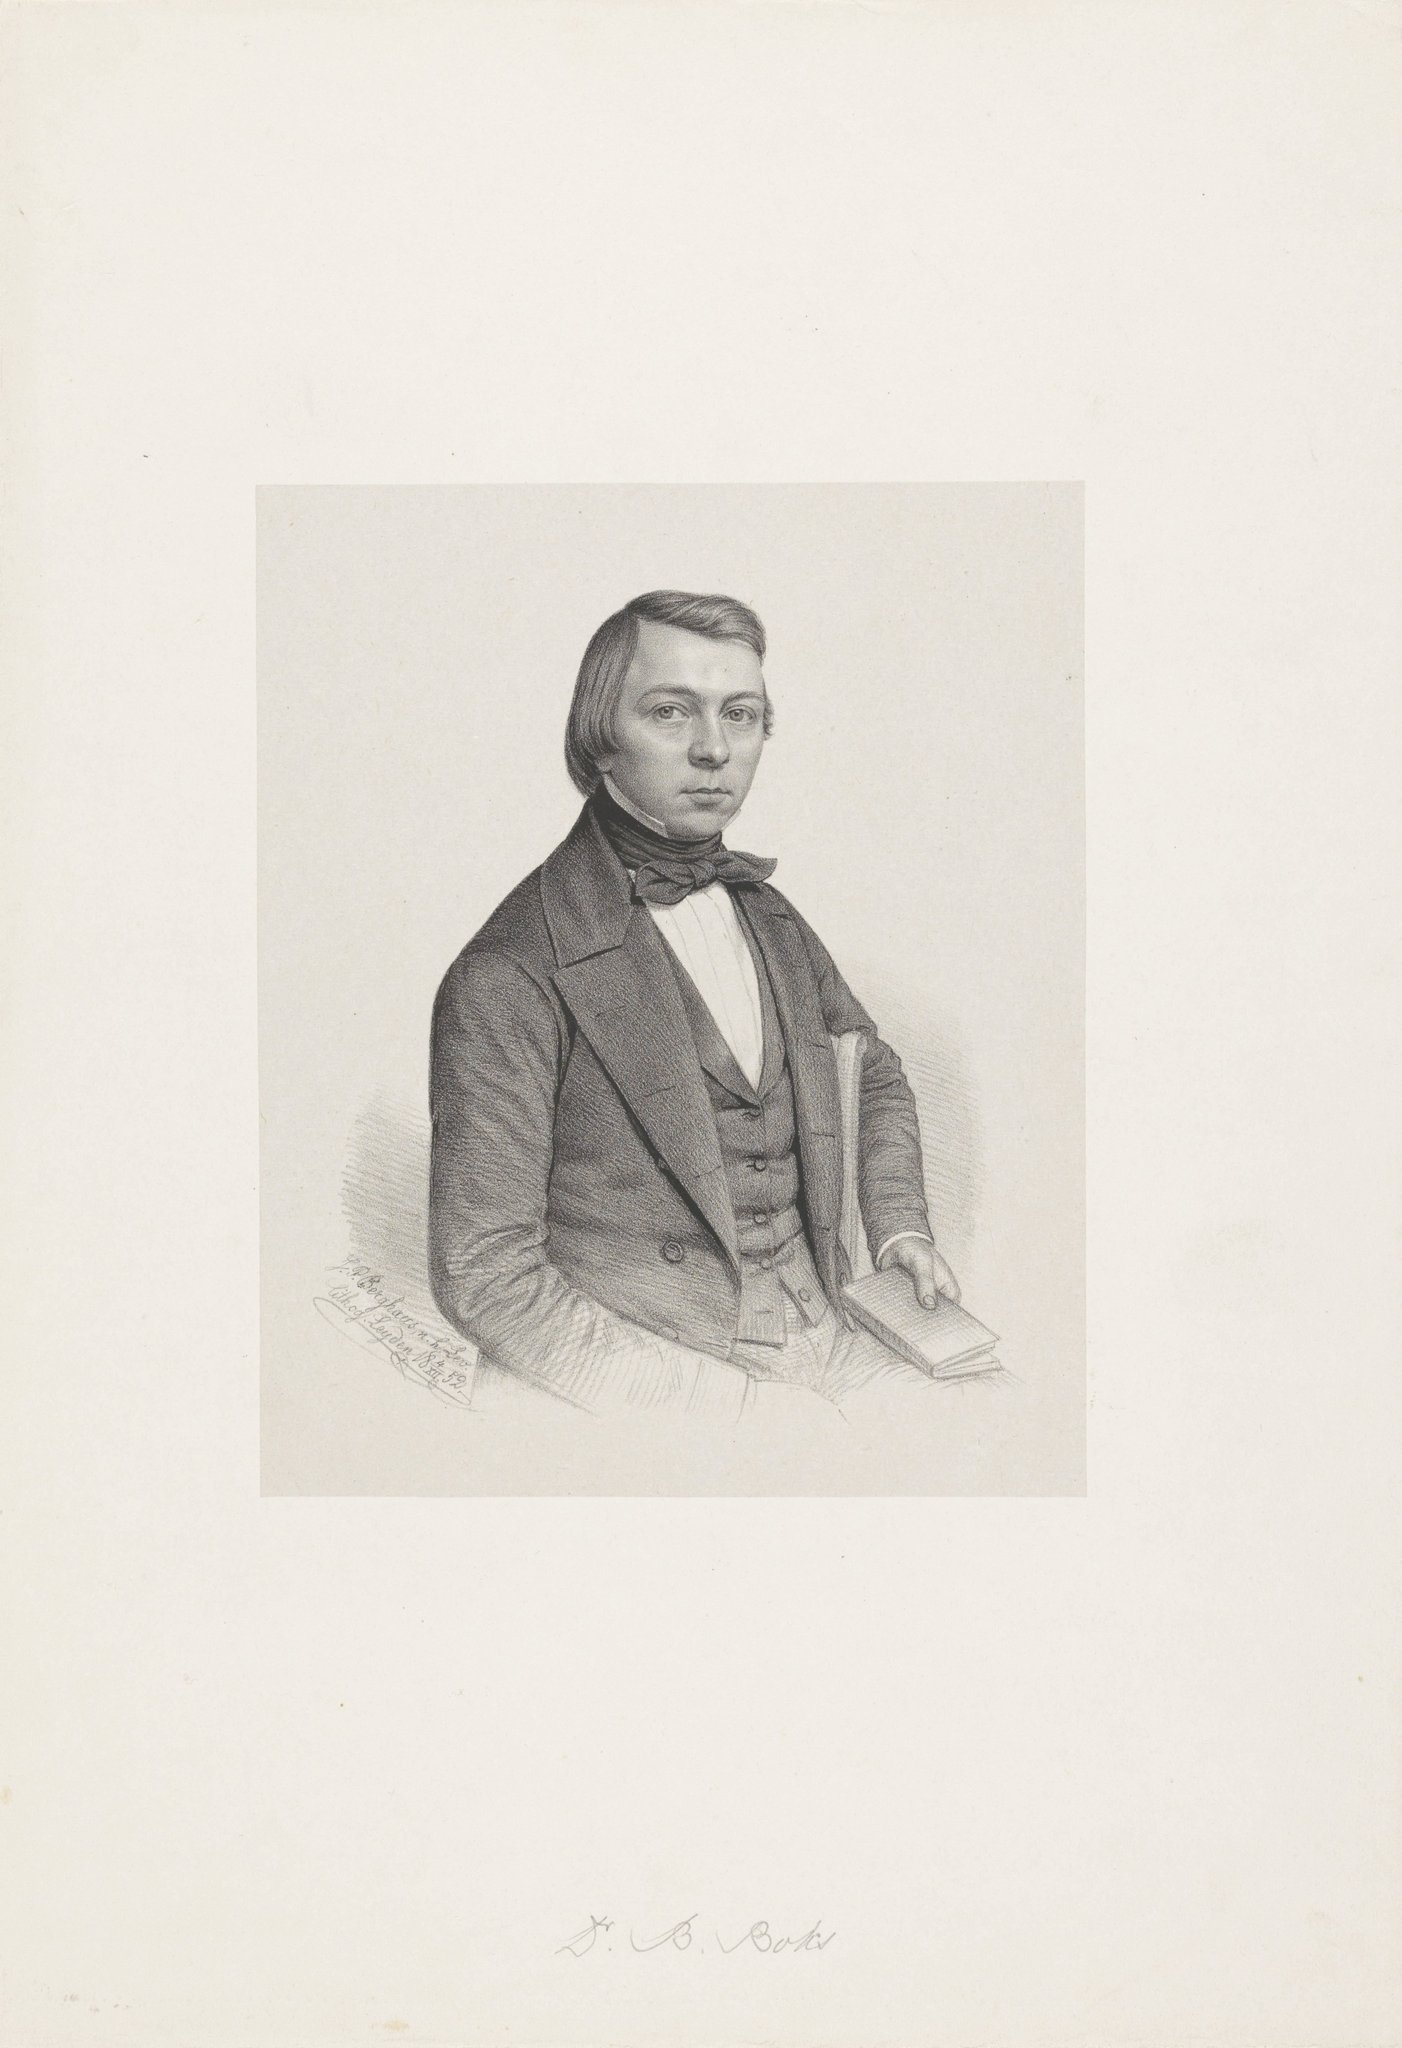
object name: print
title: Portret van B. Boks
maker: johann peter berghaus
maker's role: print maker, printer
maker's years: 1810-1870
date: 1852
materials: paper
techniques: lithograph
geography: leiden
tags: historical persons, book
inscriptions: inscription: ‘Dr. B. Boks. 31 Jan 1831 gepromoveerd te leiden. (...)’, collector's mark: Lugt 2228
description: De geportretteerde zit op een stoel en heeft een boek in zijn linkerhand. Beiden handen rusten op zijn dijbenen.